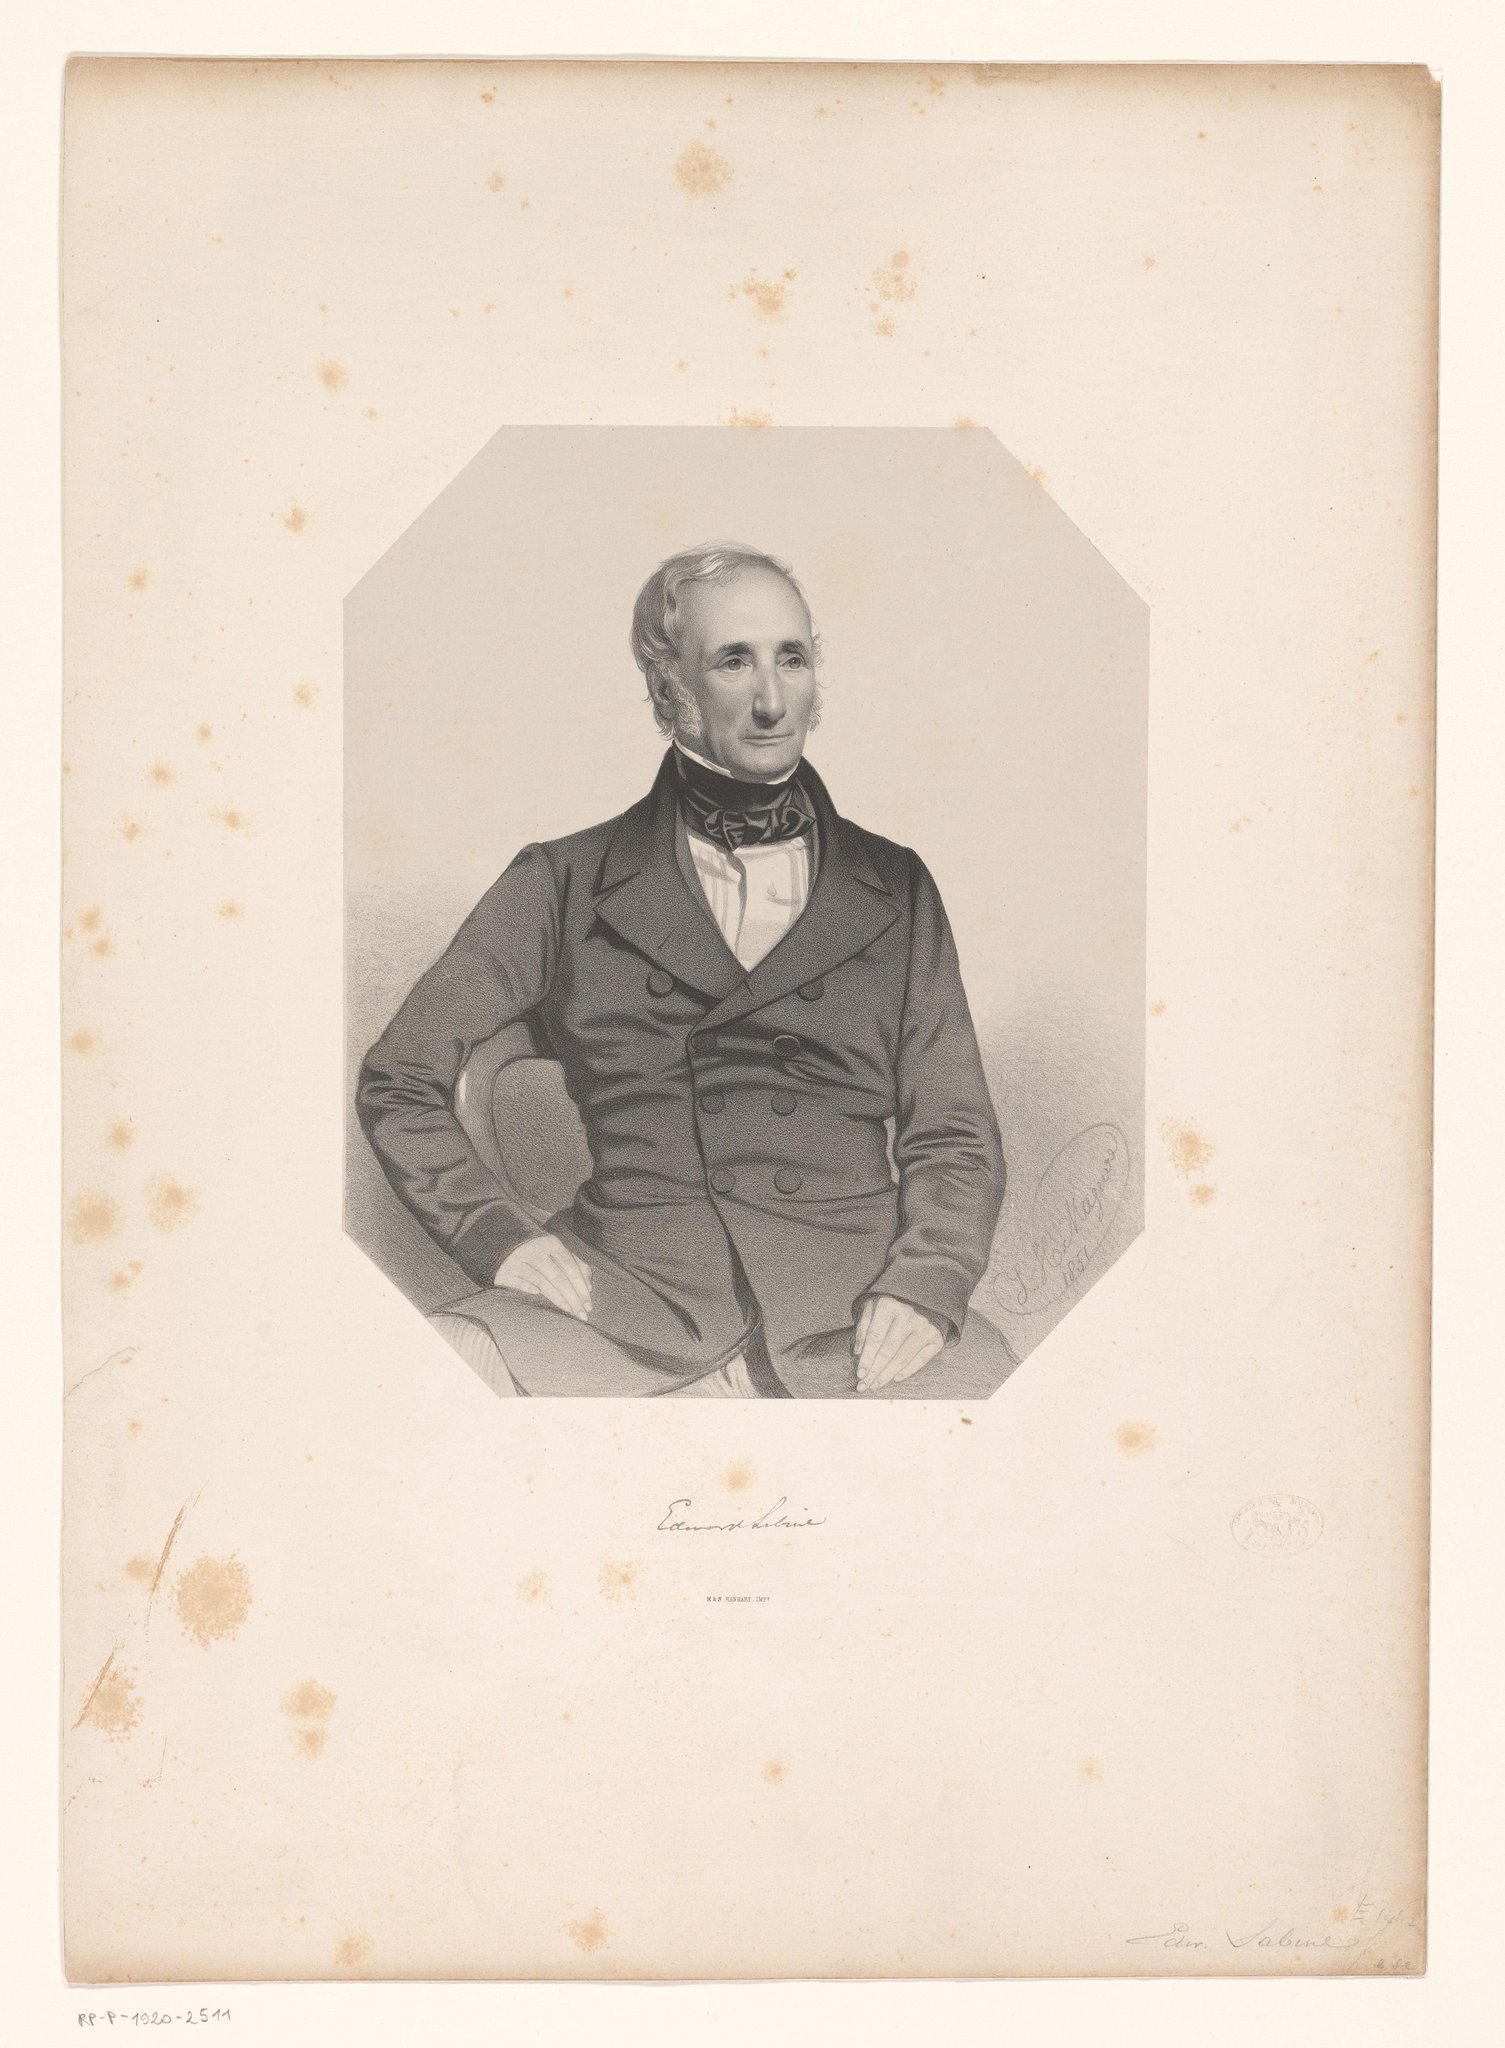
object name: print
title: Portretten uit het Ipswich Museum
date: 1852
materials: paper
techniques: lithograph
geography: london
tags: adult man, historical persons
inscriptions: collector's mark: Lugt 2228, check stamp: ‘Ipswich Museum’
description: Prent behoort tot de serie 'Ipswich Museum Portraits', ook bekend onder de titel 'Portraits of Honorary Members of the Ipswich Museum'. Deze serie is in 1852 door George Ransome uitgegeven en gedrukt door M&N Hanhart tussen 1848 en 1852. De serie bestaat uit ca. 60 portretten.